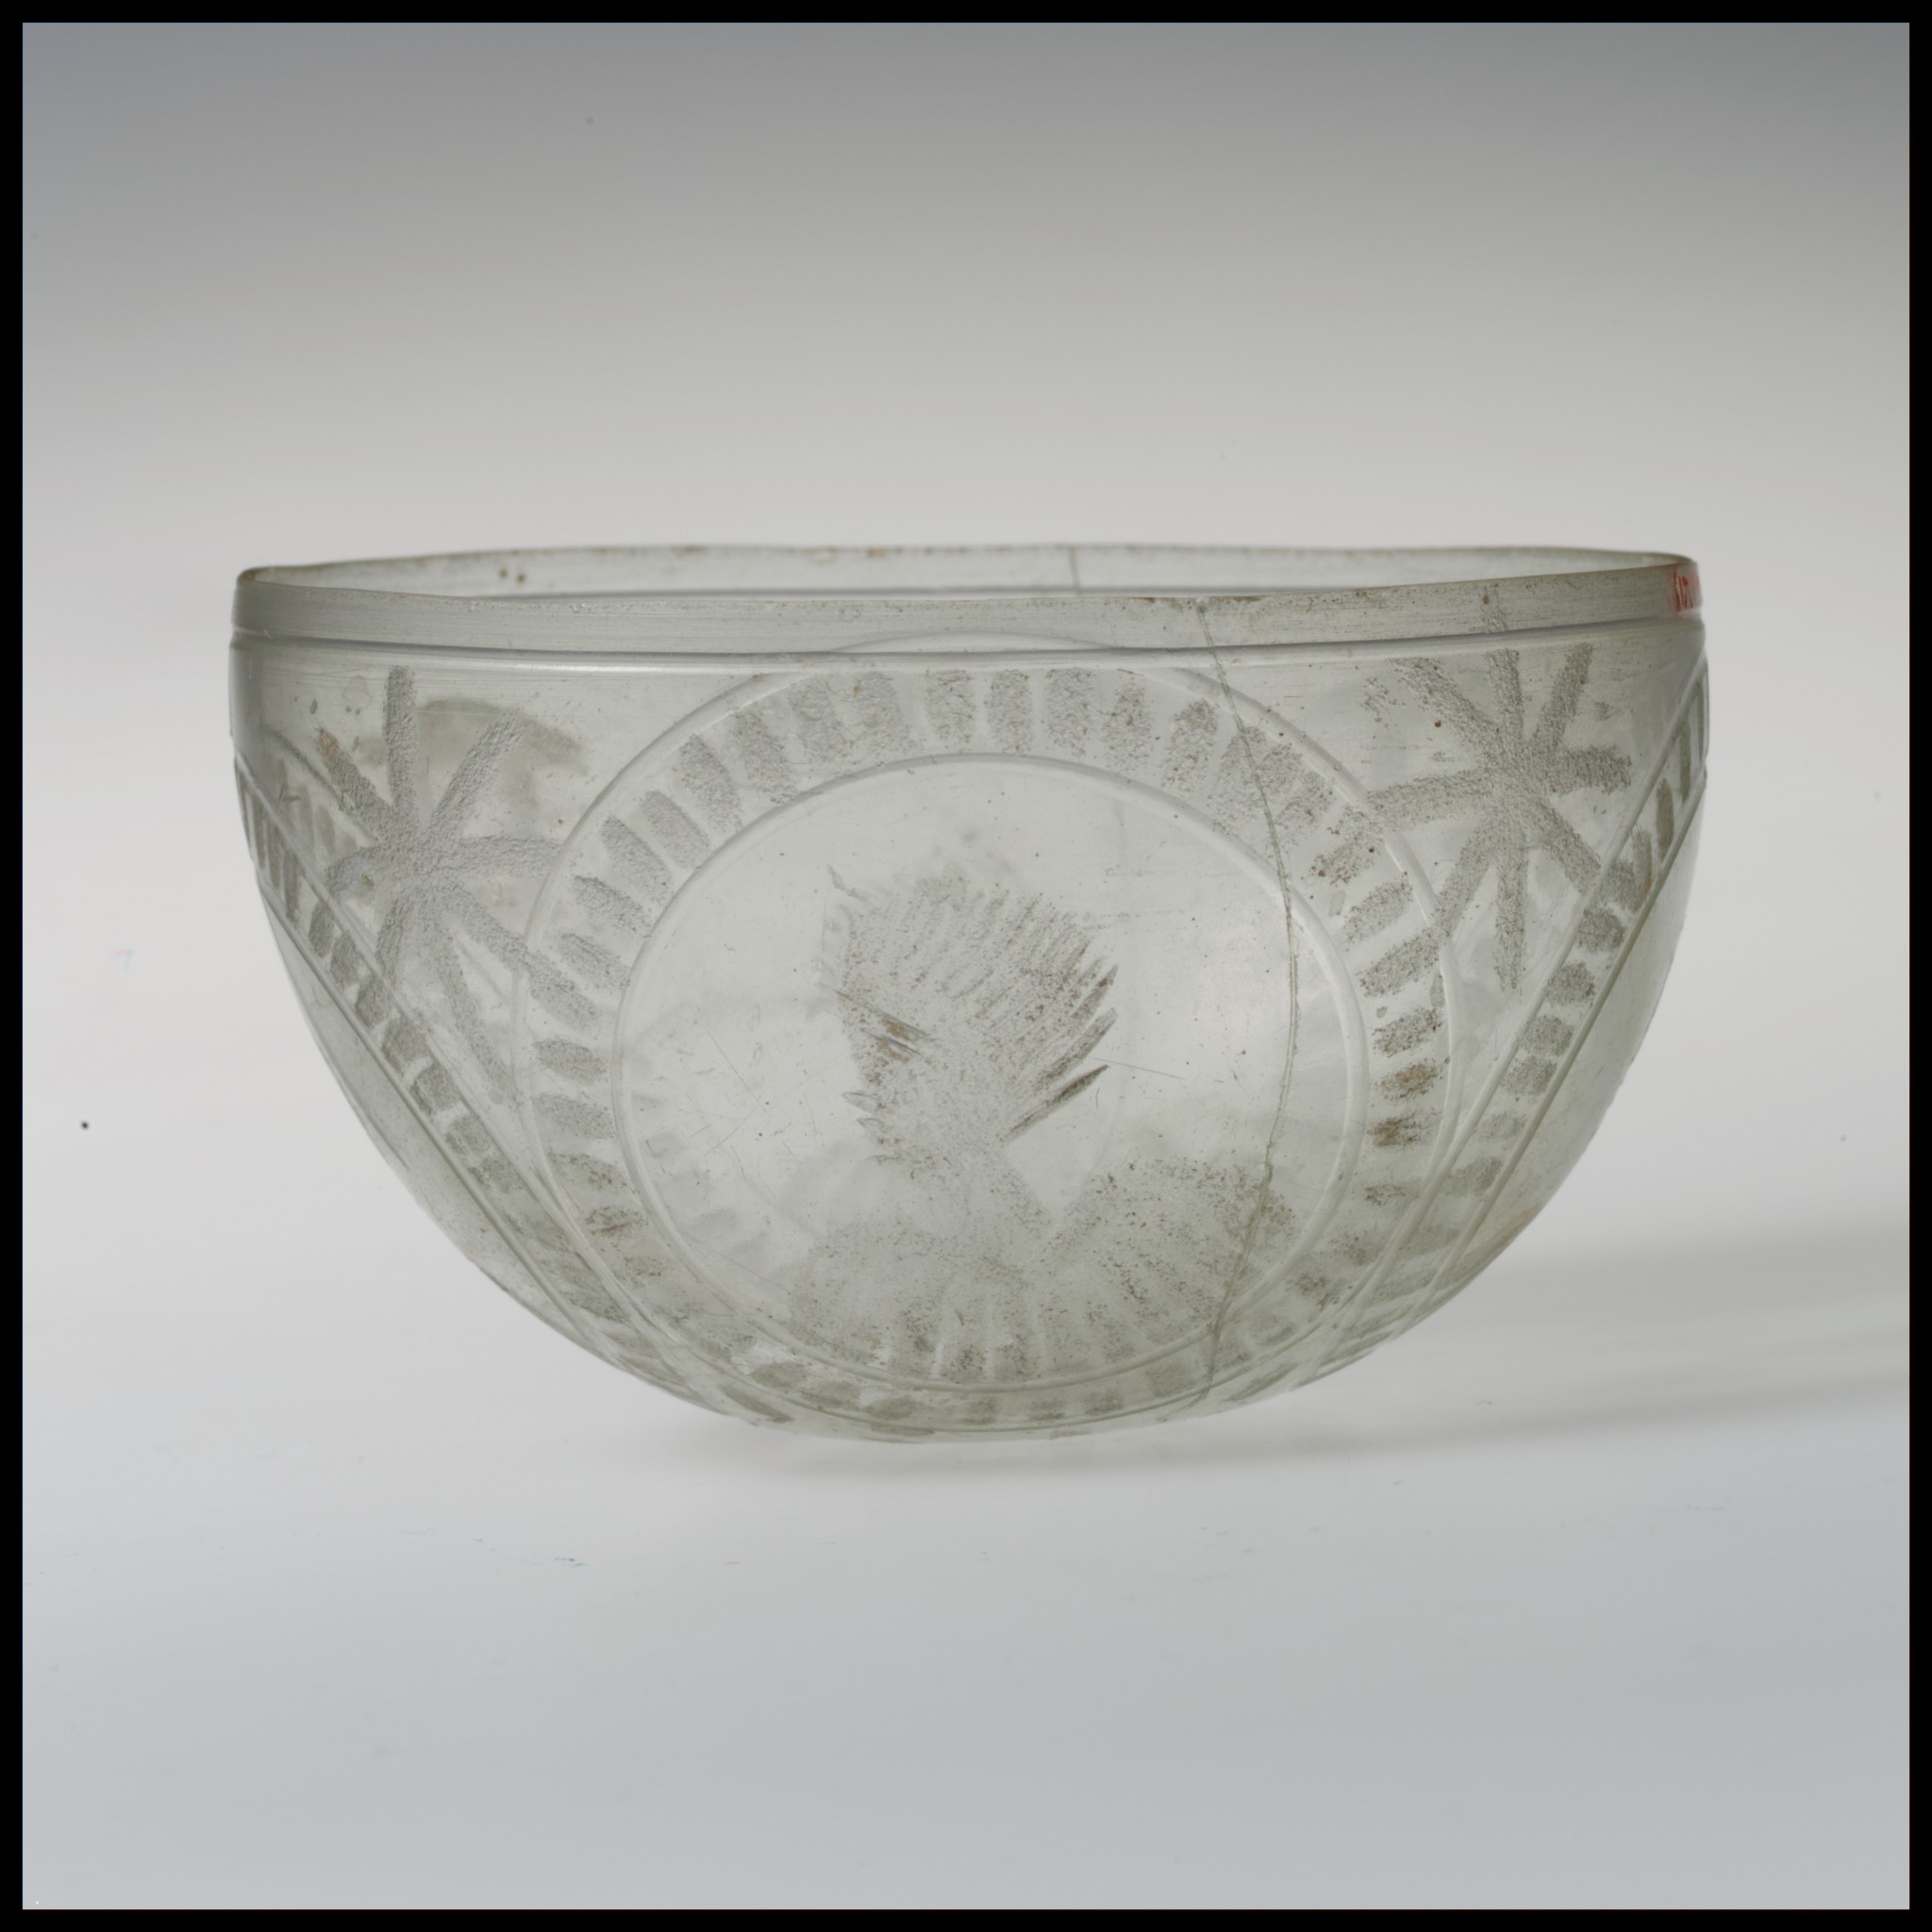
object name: bowl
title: Glass bowl decorated with four busts in roundels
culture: roman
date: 301-400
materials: glass